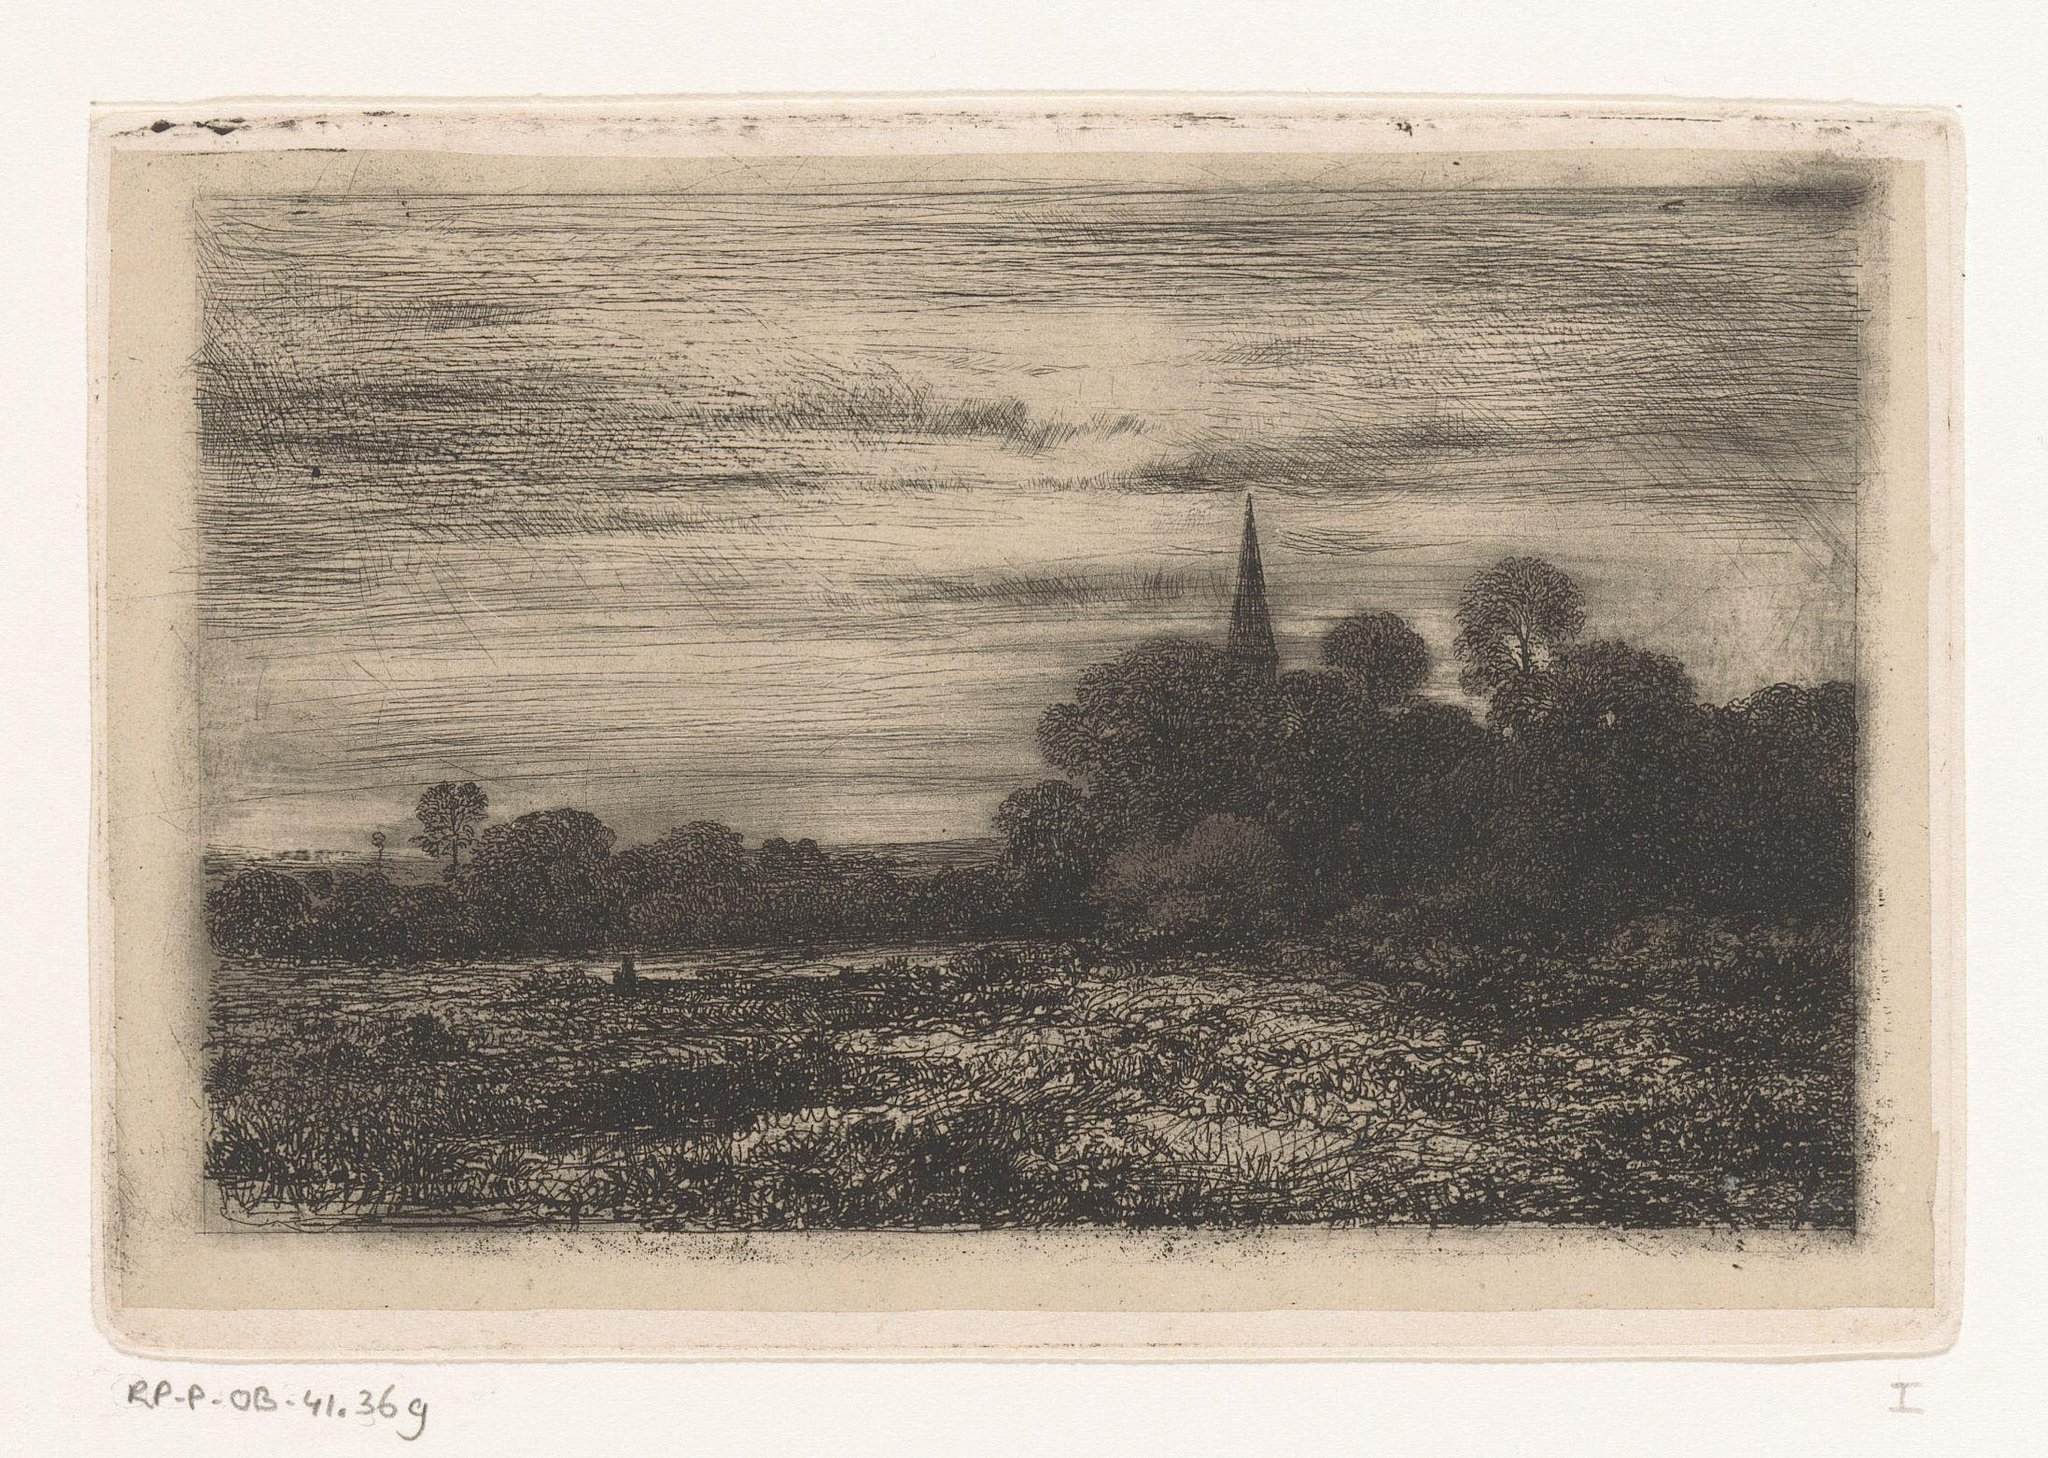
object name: print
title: Landschap met kerktoren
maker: jean alexis achard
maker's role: print maker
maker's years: 1807-1884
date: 1851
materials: paper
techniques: etching, intaglio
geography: france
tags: trees, landscapes, parts of church exterior and annexes: spire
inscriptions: inscription: ‘Épreuve unique / 1er état’, collector's mark: Lugt 2228